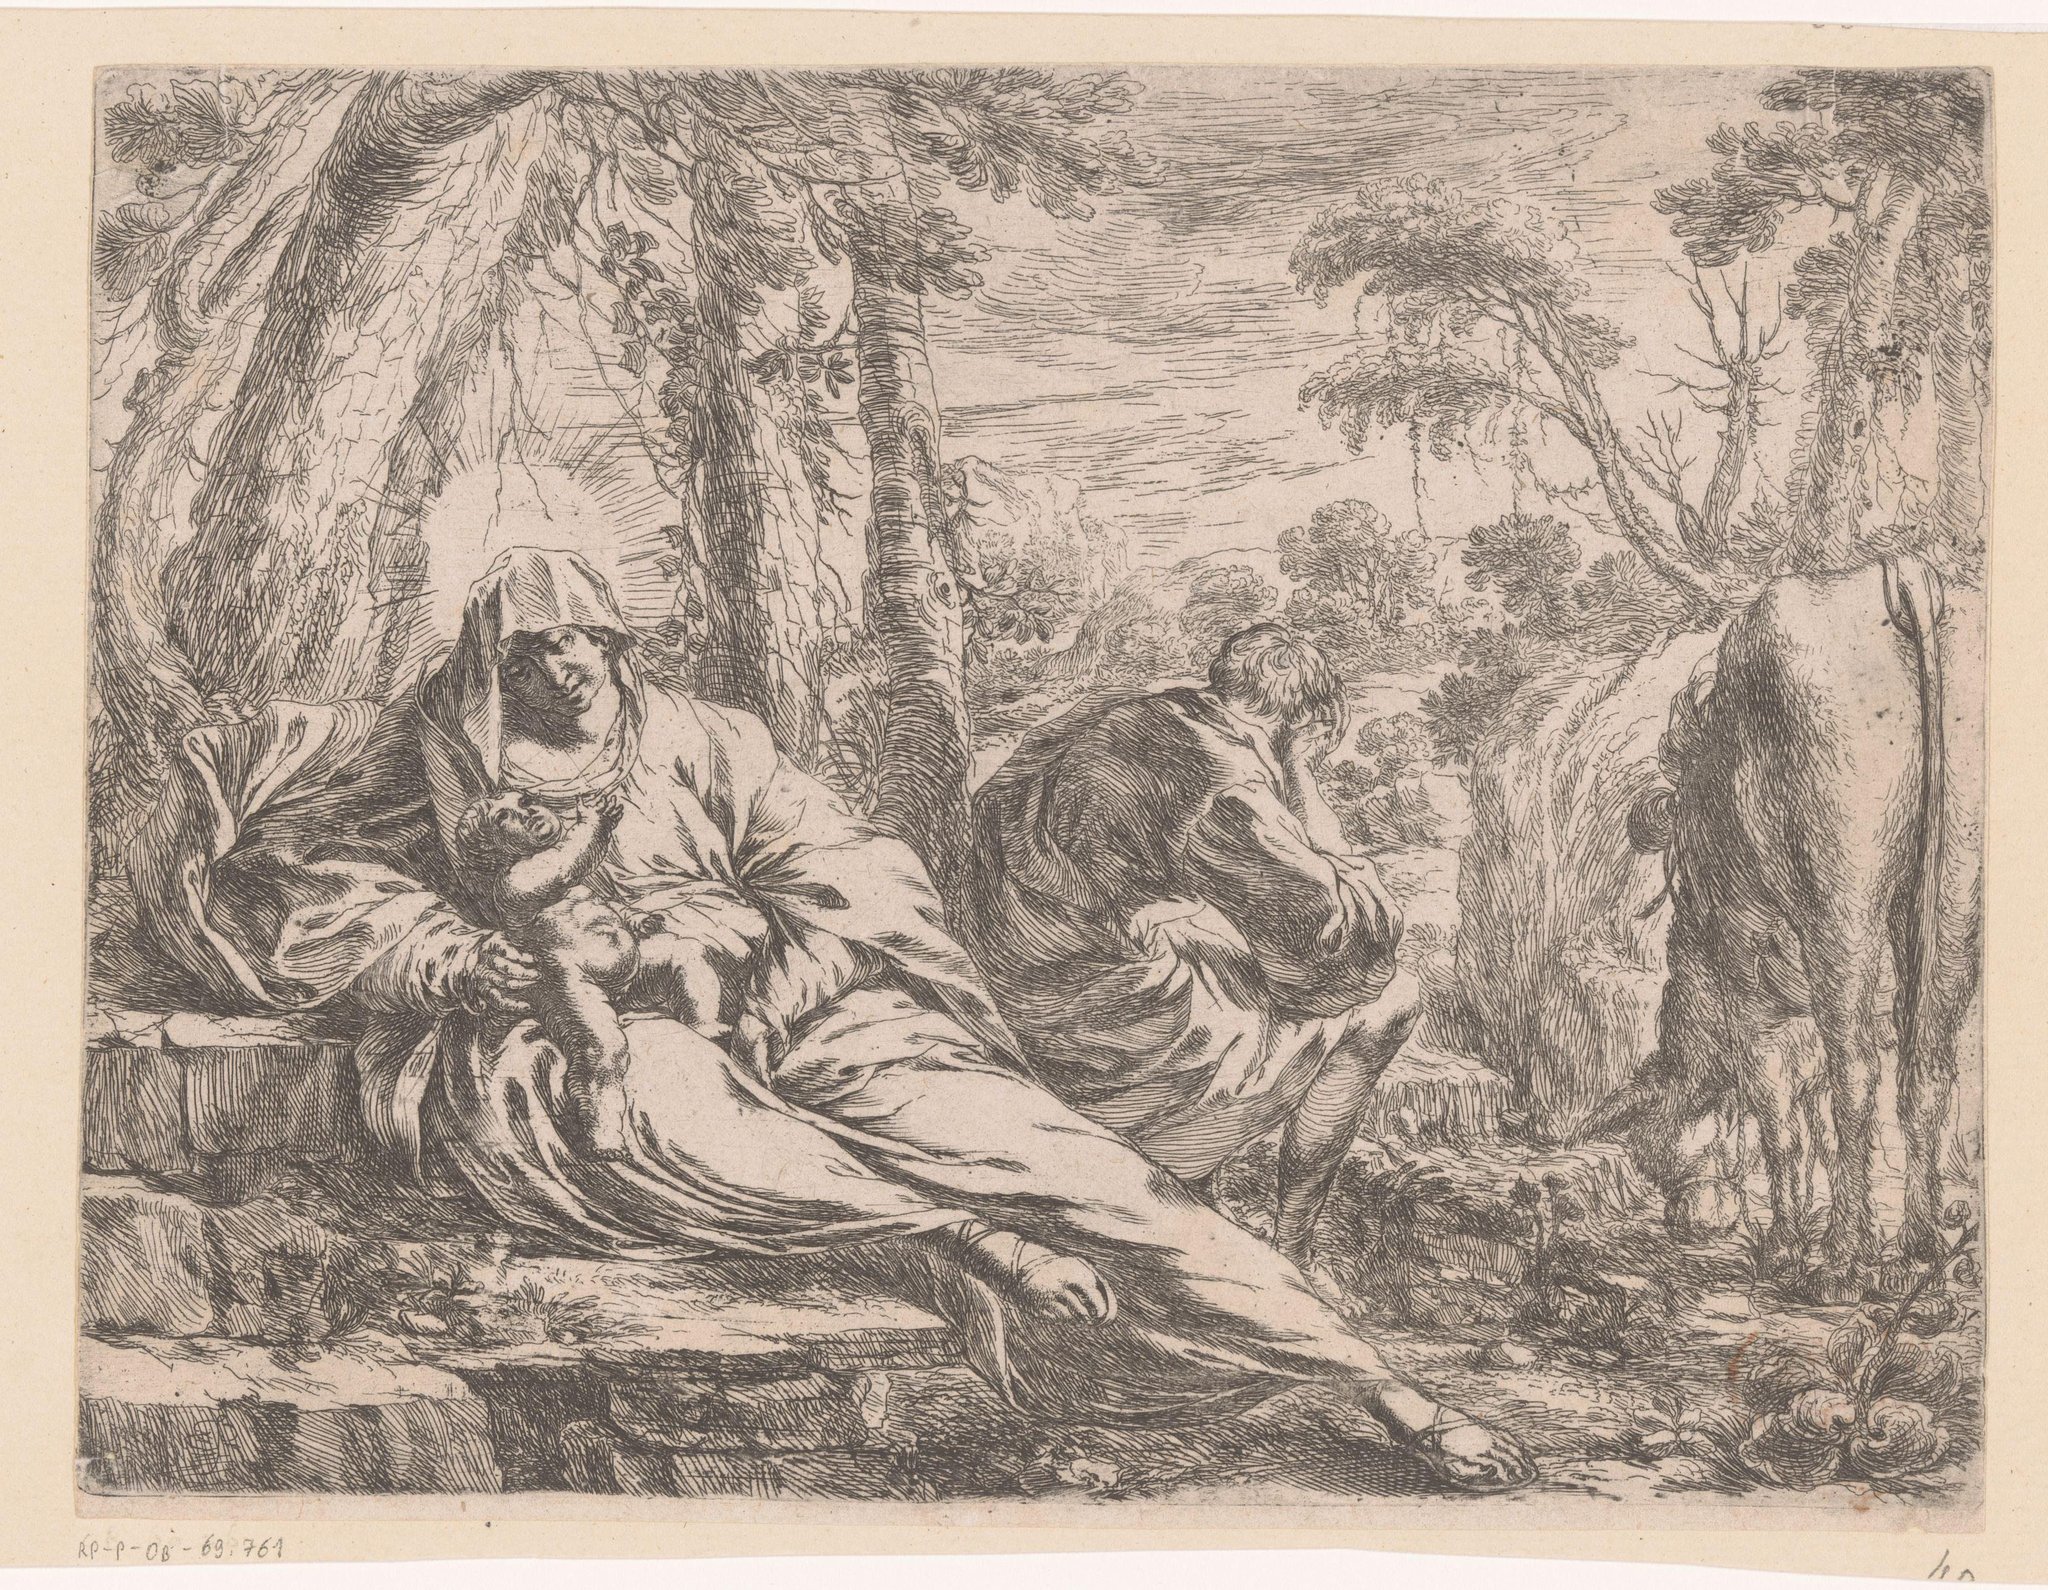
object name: print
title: Rust op de vlucht naar Egypte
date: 1612-1686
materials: paper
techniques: engraving, etching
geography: france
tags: rest on the flight into egypt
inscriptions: collector's mark: Lugt 240